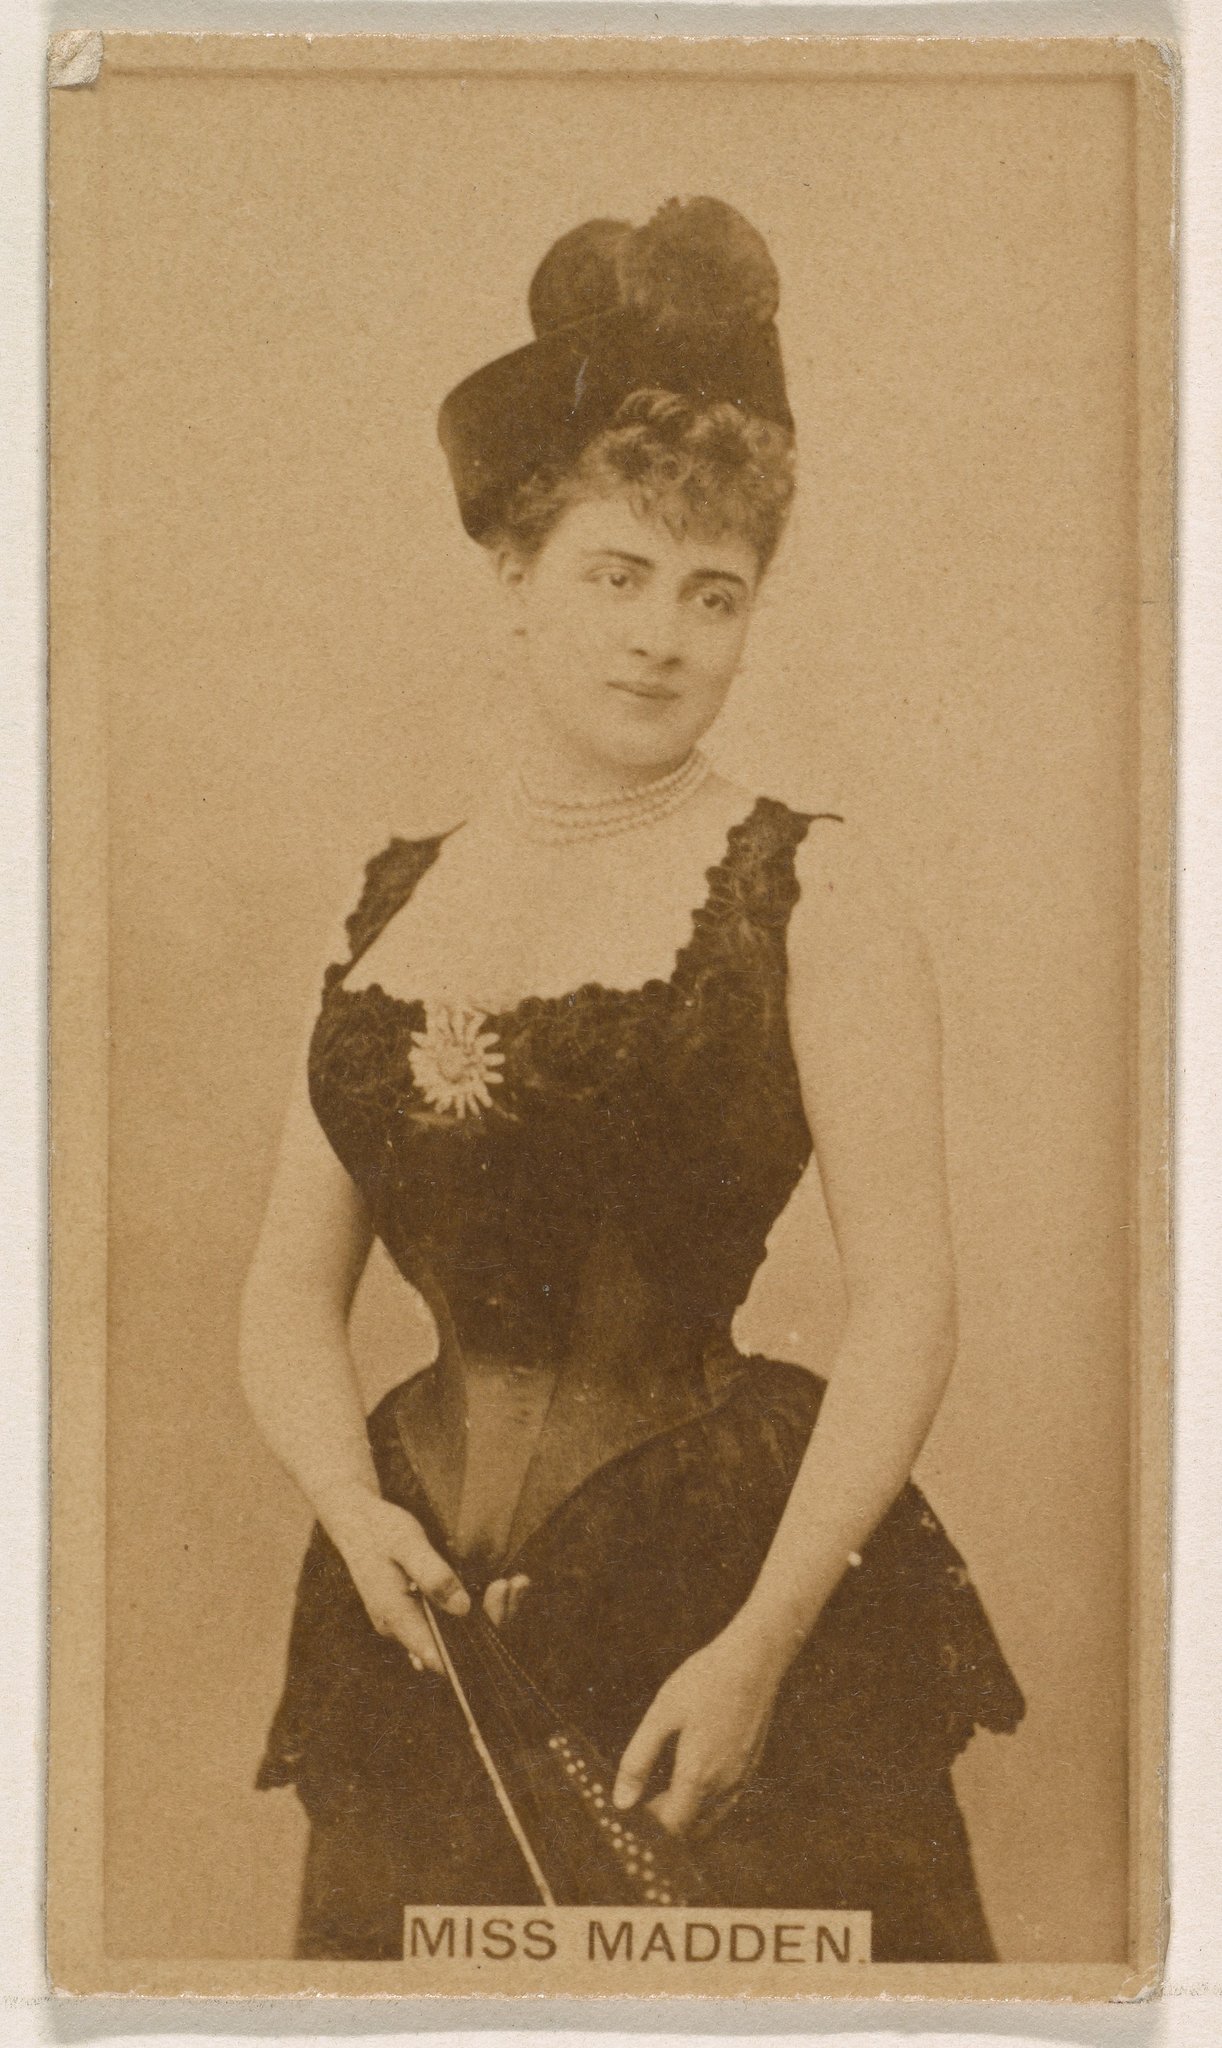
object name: photograph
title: Miss Madden, from the Actresses series (N245) issued by Kinney Brothers to promote Sweet Caporal Cigarettes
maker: kinney brothers tobacco company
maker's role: publisher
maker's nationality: american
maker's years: 1869-2011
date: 1890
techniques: albumen silver print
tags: portraits,women,actresses